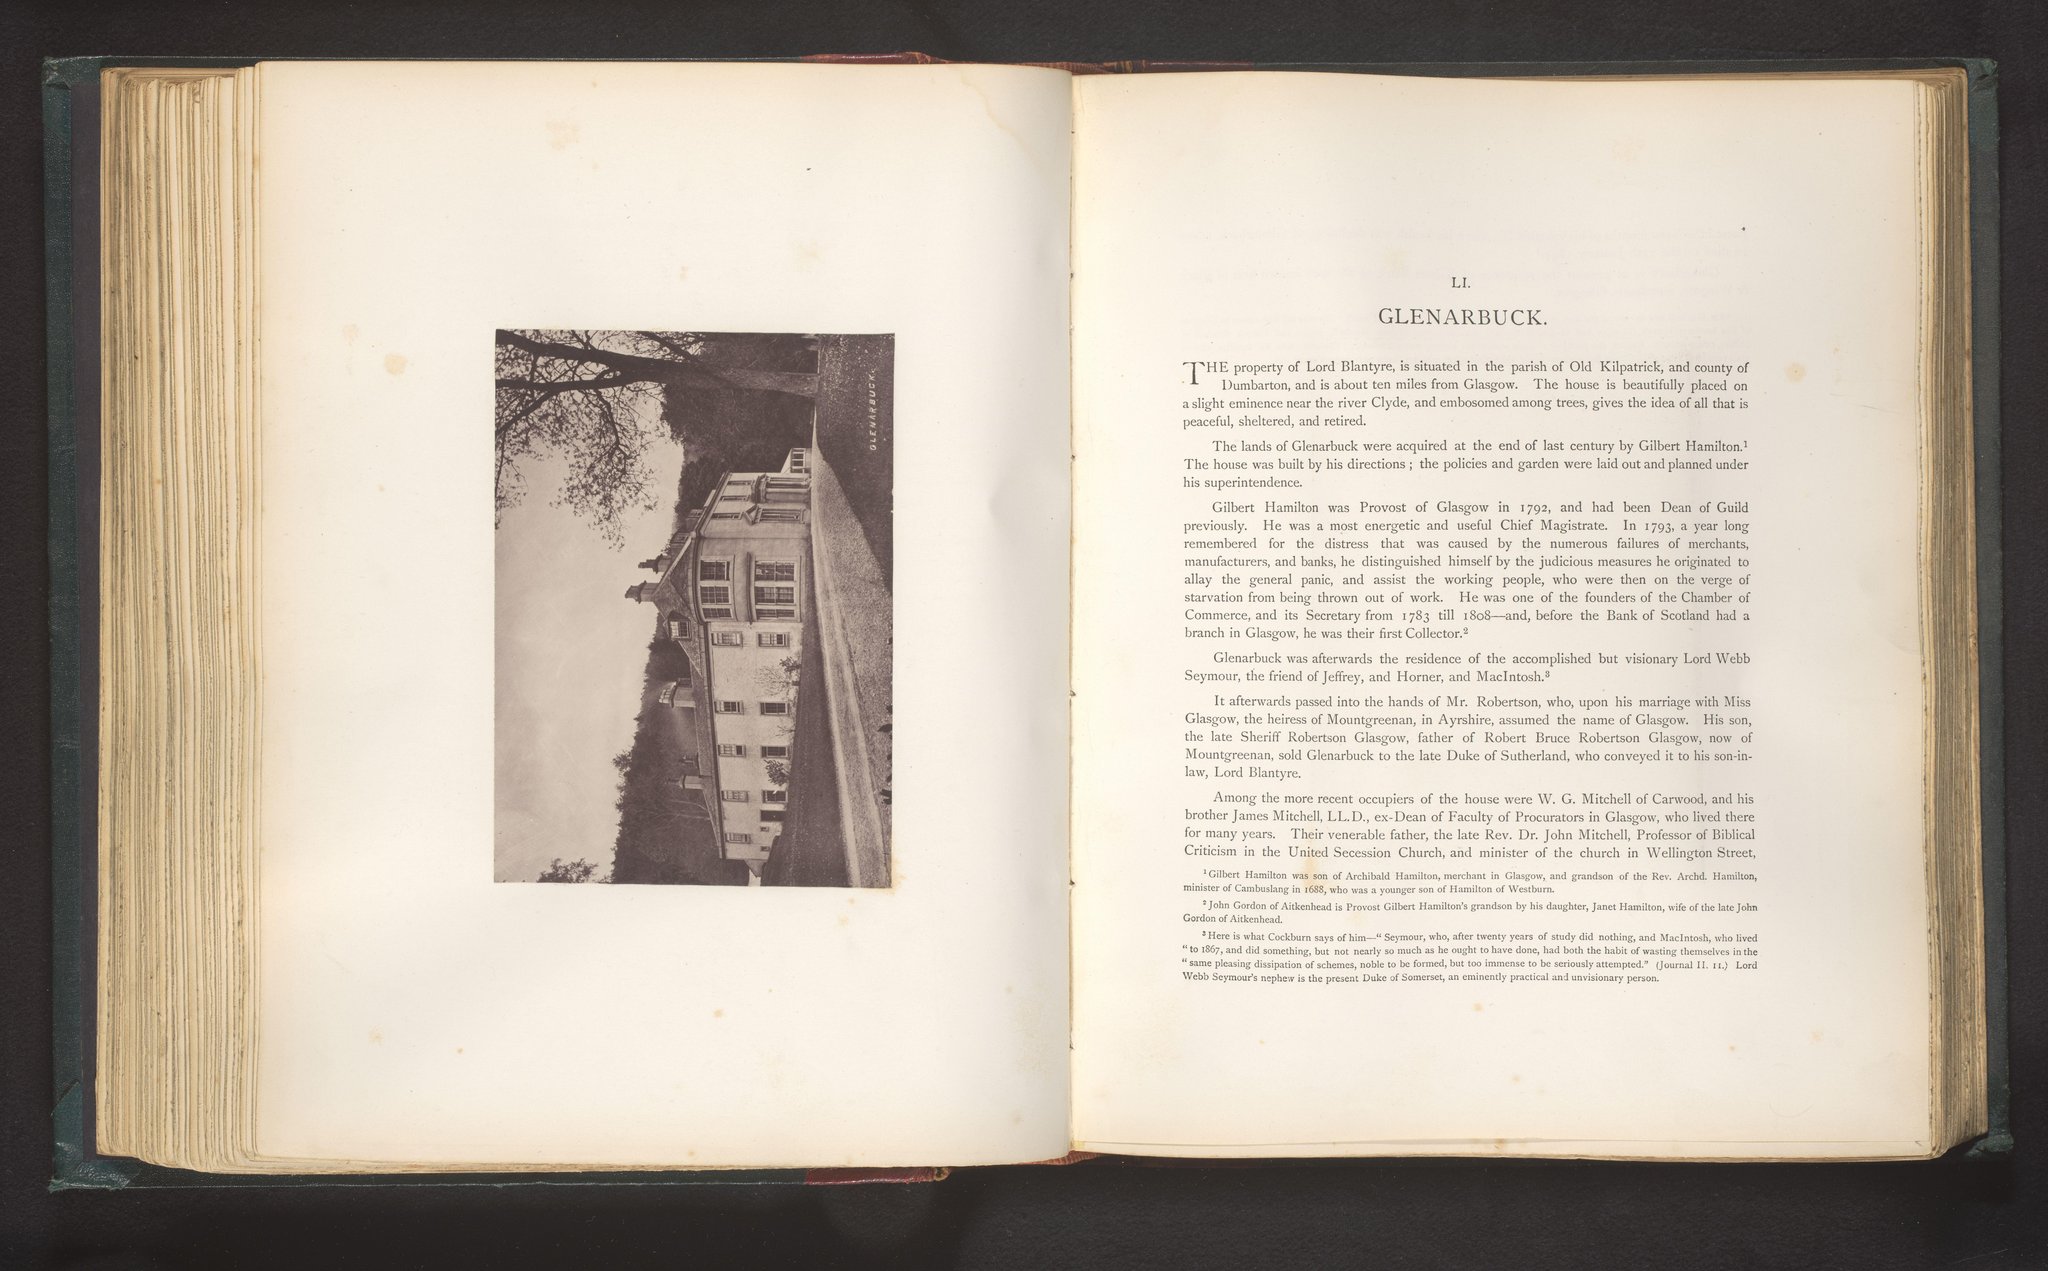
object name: photograph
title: Glenarbuck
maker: thomas annan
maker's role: fotograaf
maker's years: 1829-1887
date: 1868-1878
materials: paper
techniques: carbon print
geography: scotland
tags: rural housing, e.g. country-house, villa, cottage, façade (of house or building)